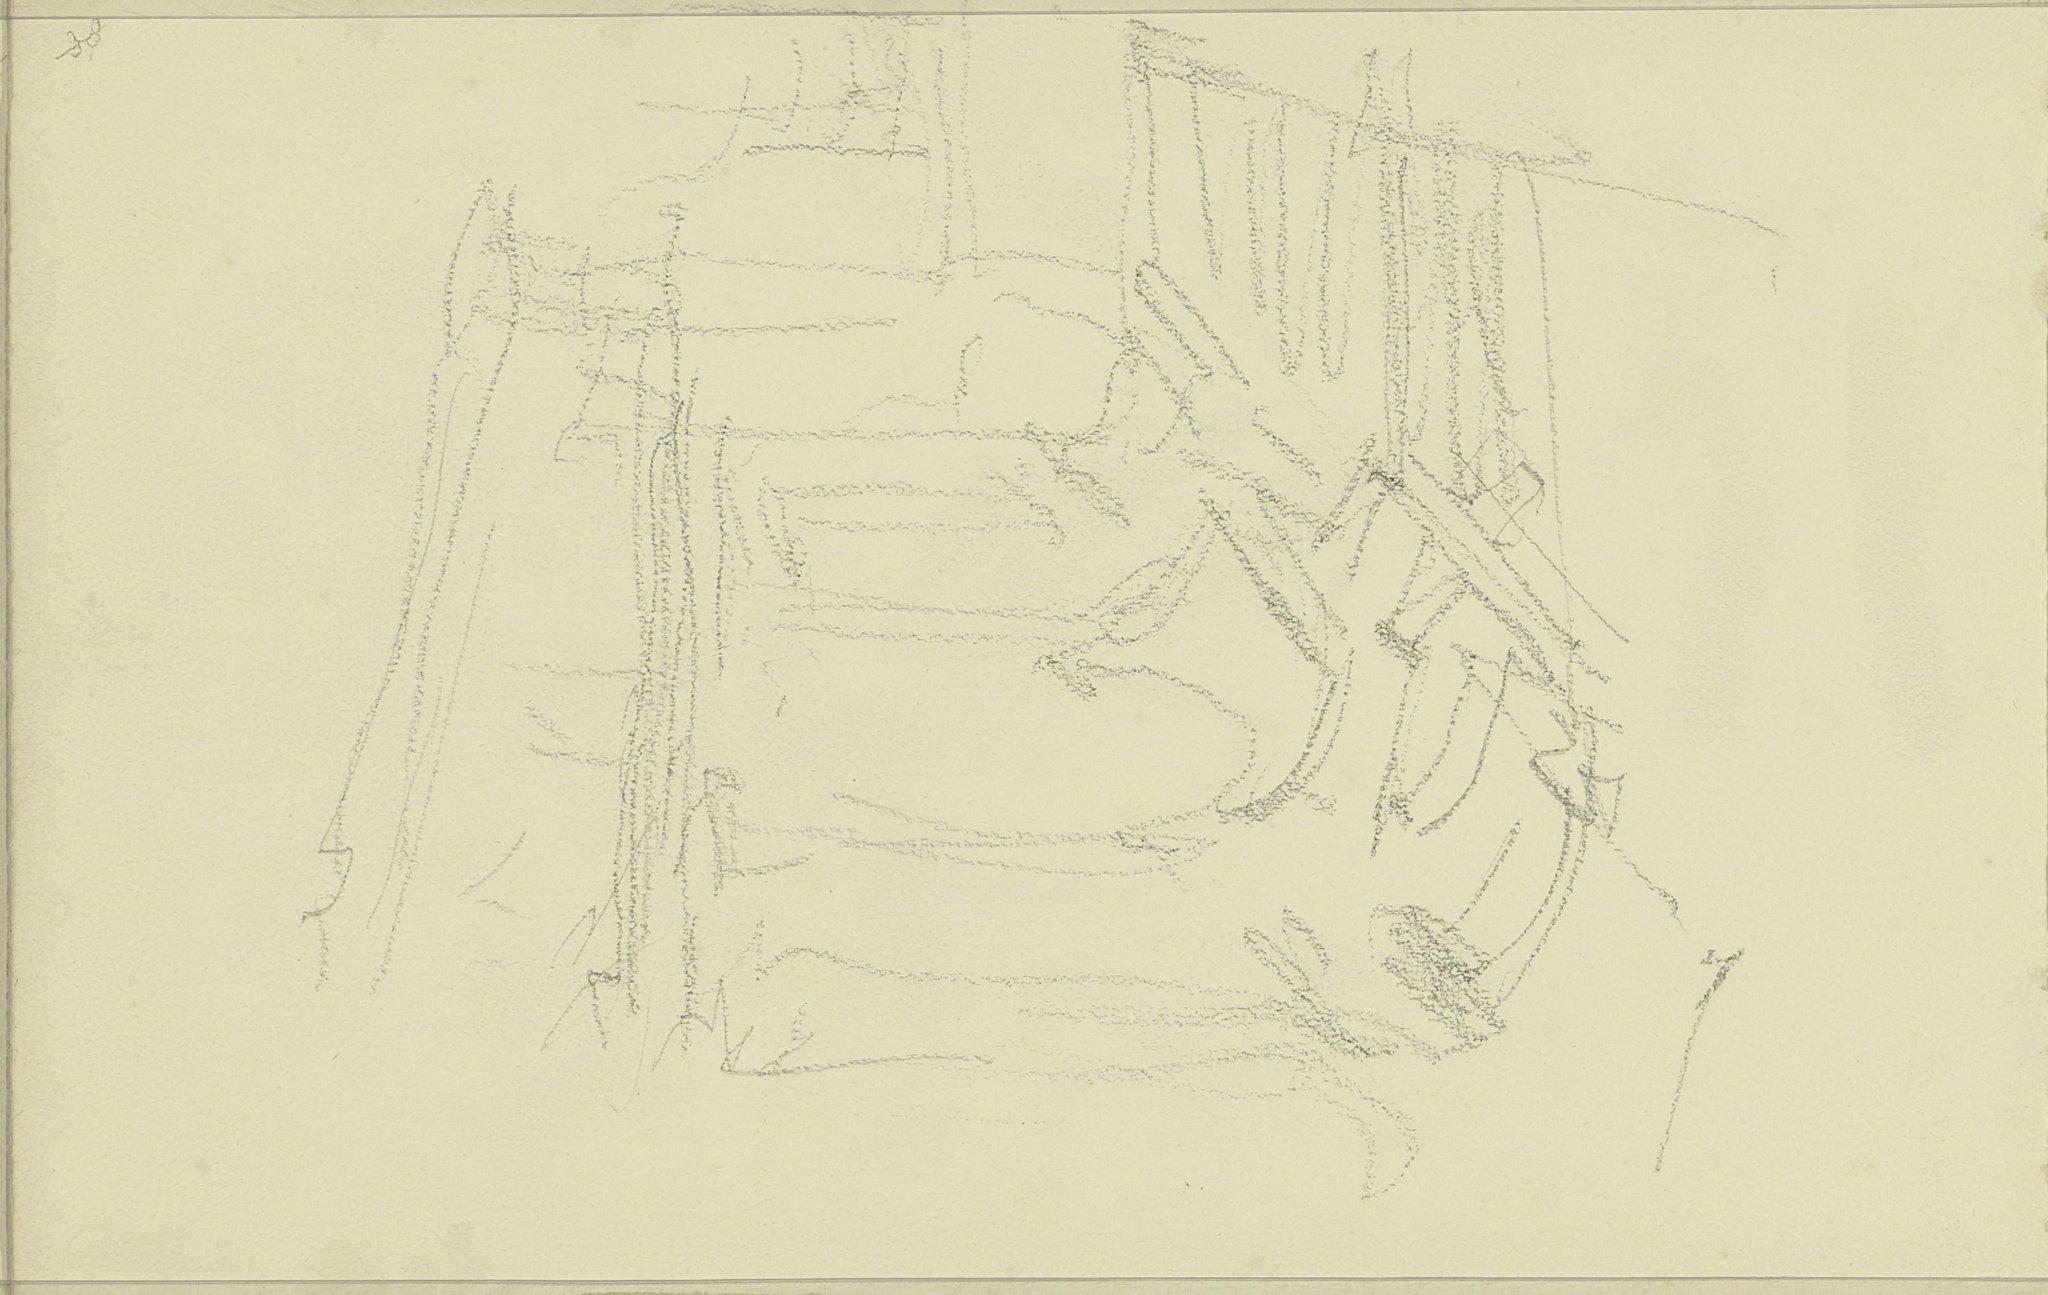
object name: sketchbook leaf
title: Galerij met bogen, mogelijk een kerkinterieur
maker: johannes bosboom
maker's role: draughtsman, painter, print maker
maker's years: 1817-1891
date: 1873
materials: paper, pencil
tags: arcade ~ architecture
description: Blad 35 verso uit een schetsboek met 39 bladen.